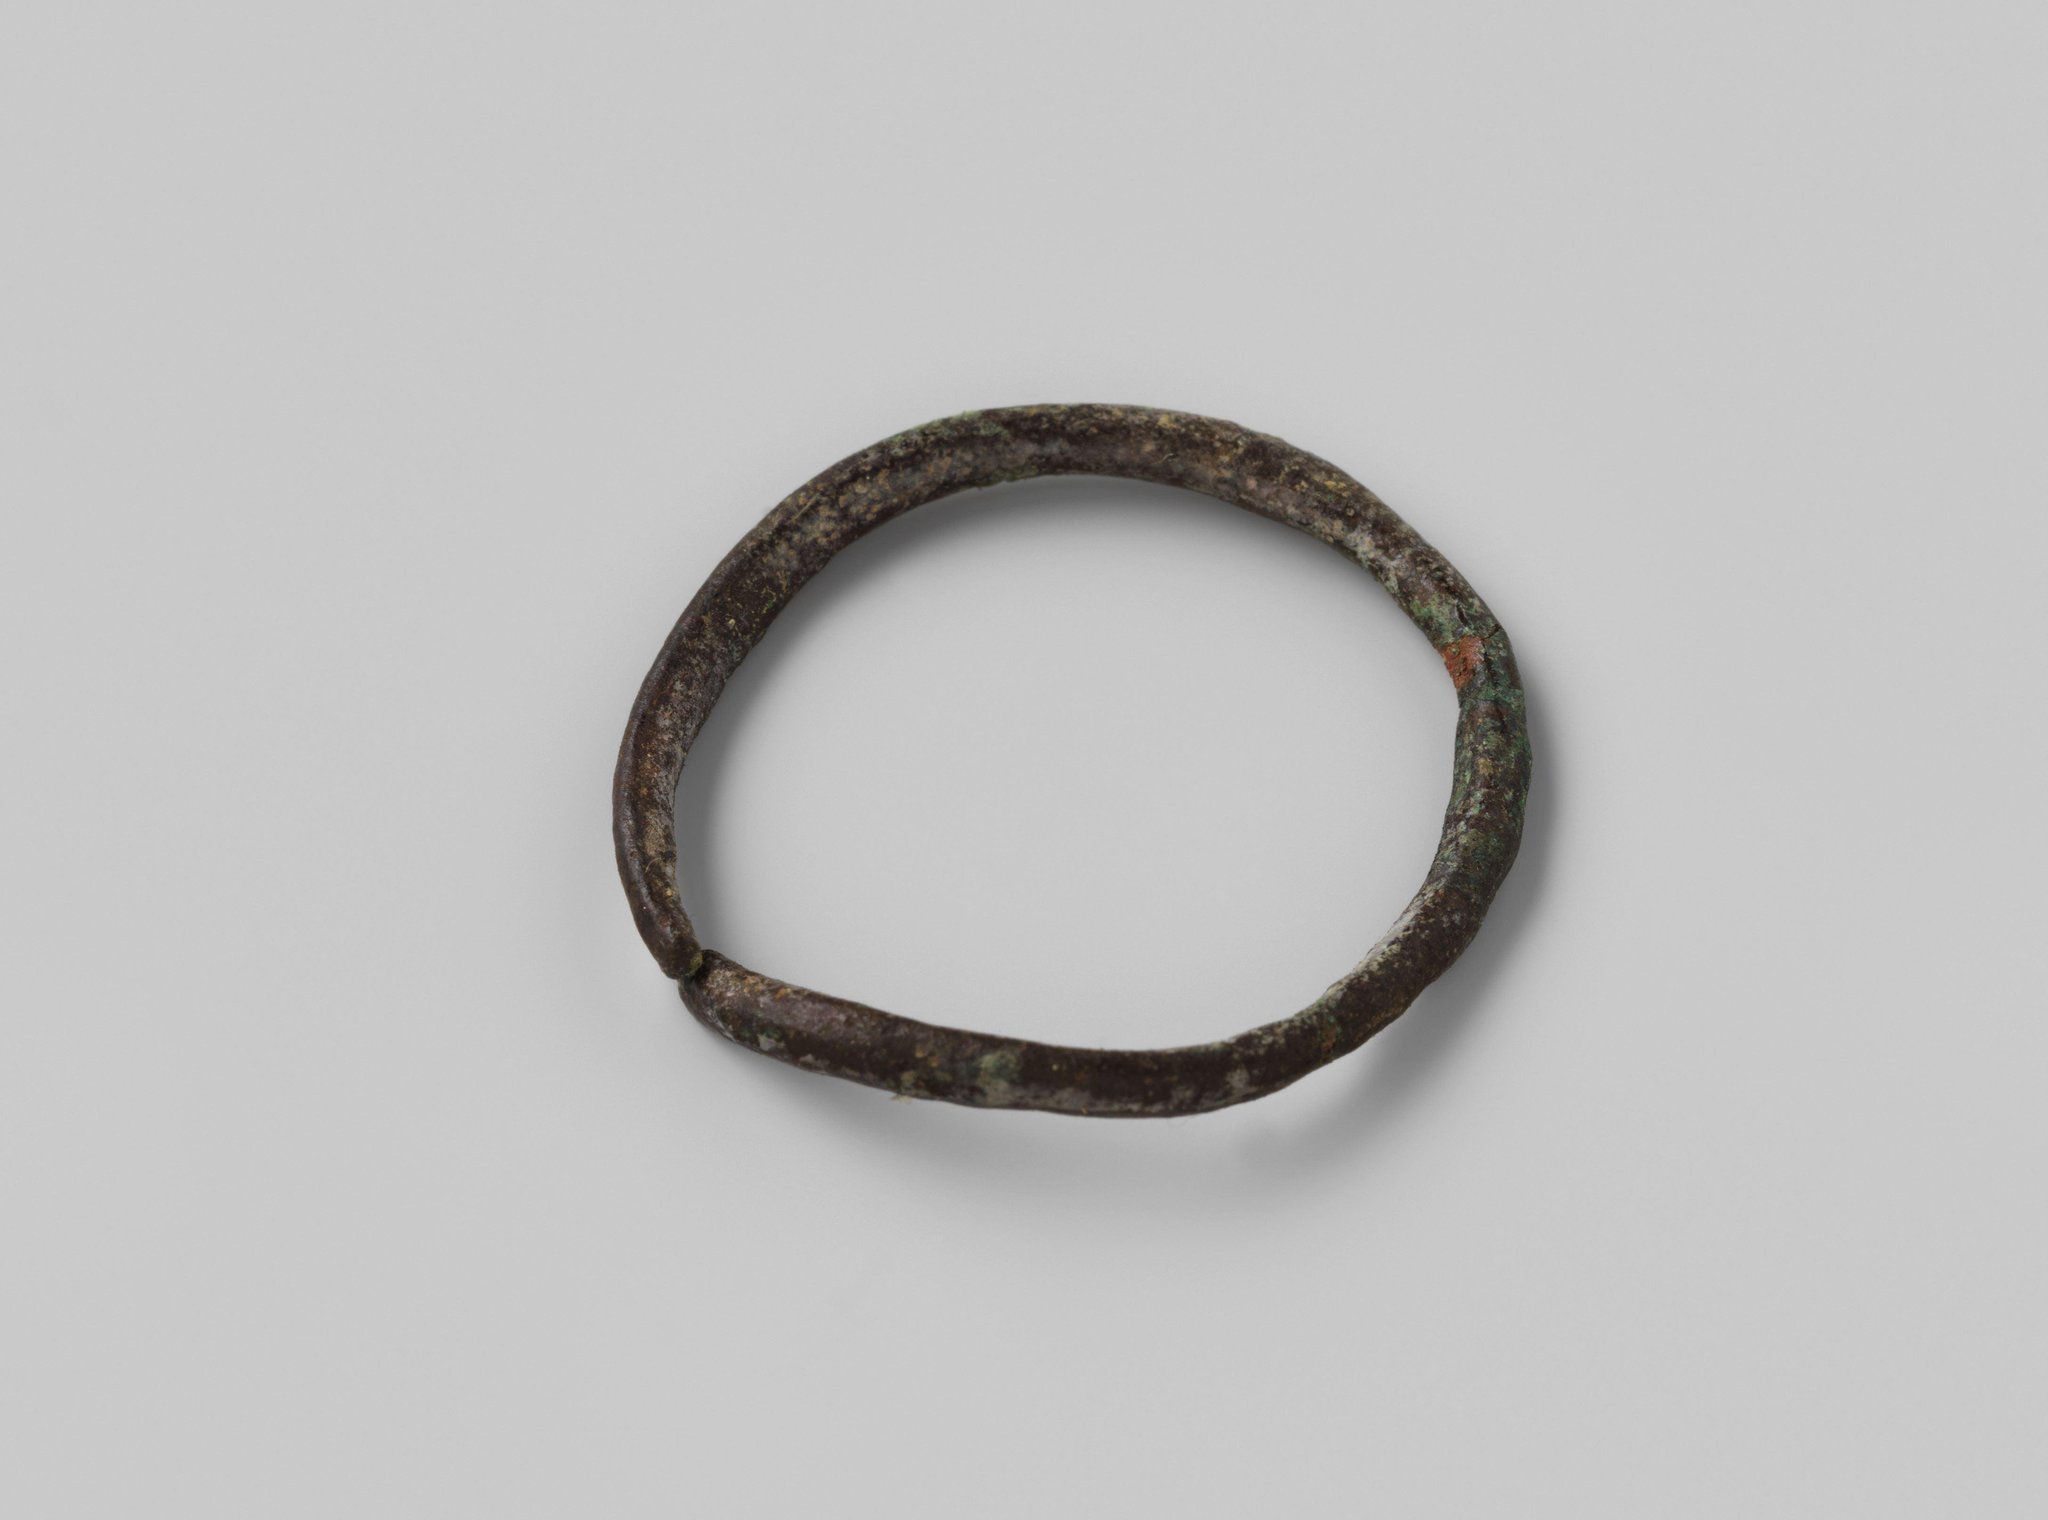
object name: fragment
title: Ringvormig fragment uit het wrak van de Oost-Indiëvaarder Hollandia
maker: Anonymous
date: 1700-1743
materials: copper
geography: netherlands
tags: verenigde oostindische compagnie, hollandia (schip), annet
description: Varied parts or fragments, rings or ring-shaped fragments; id. 80H946.